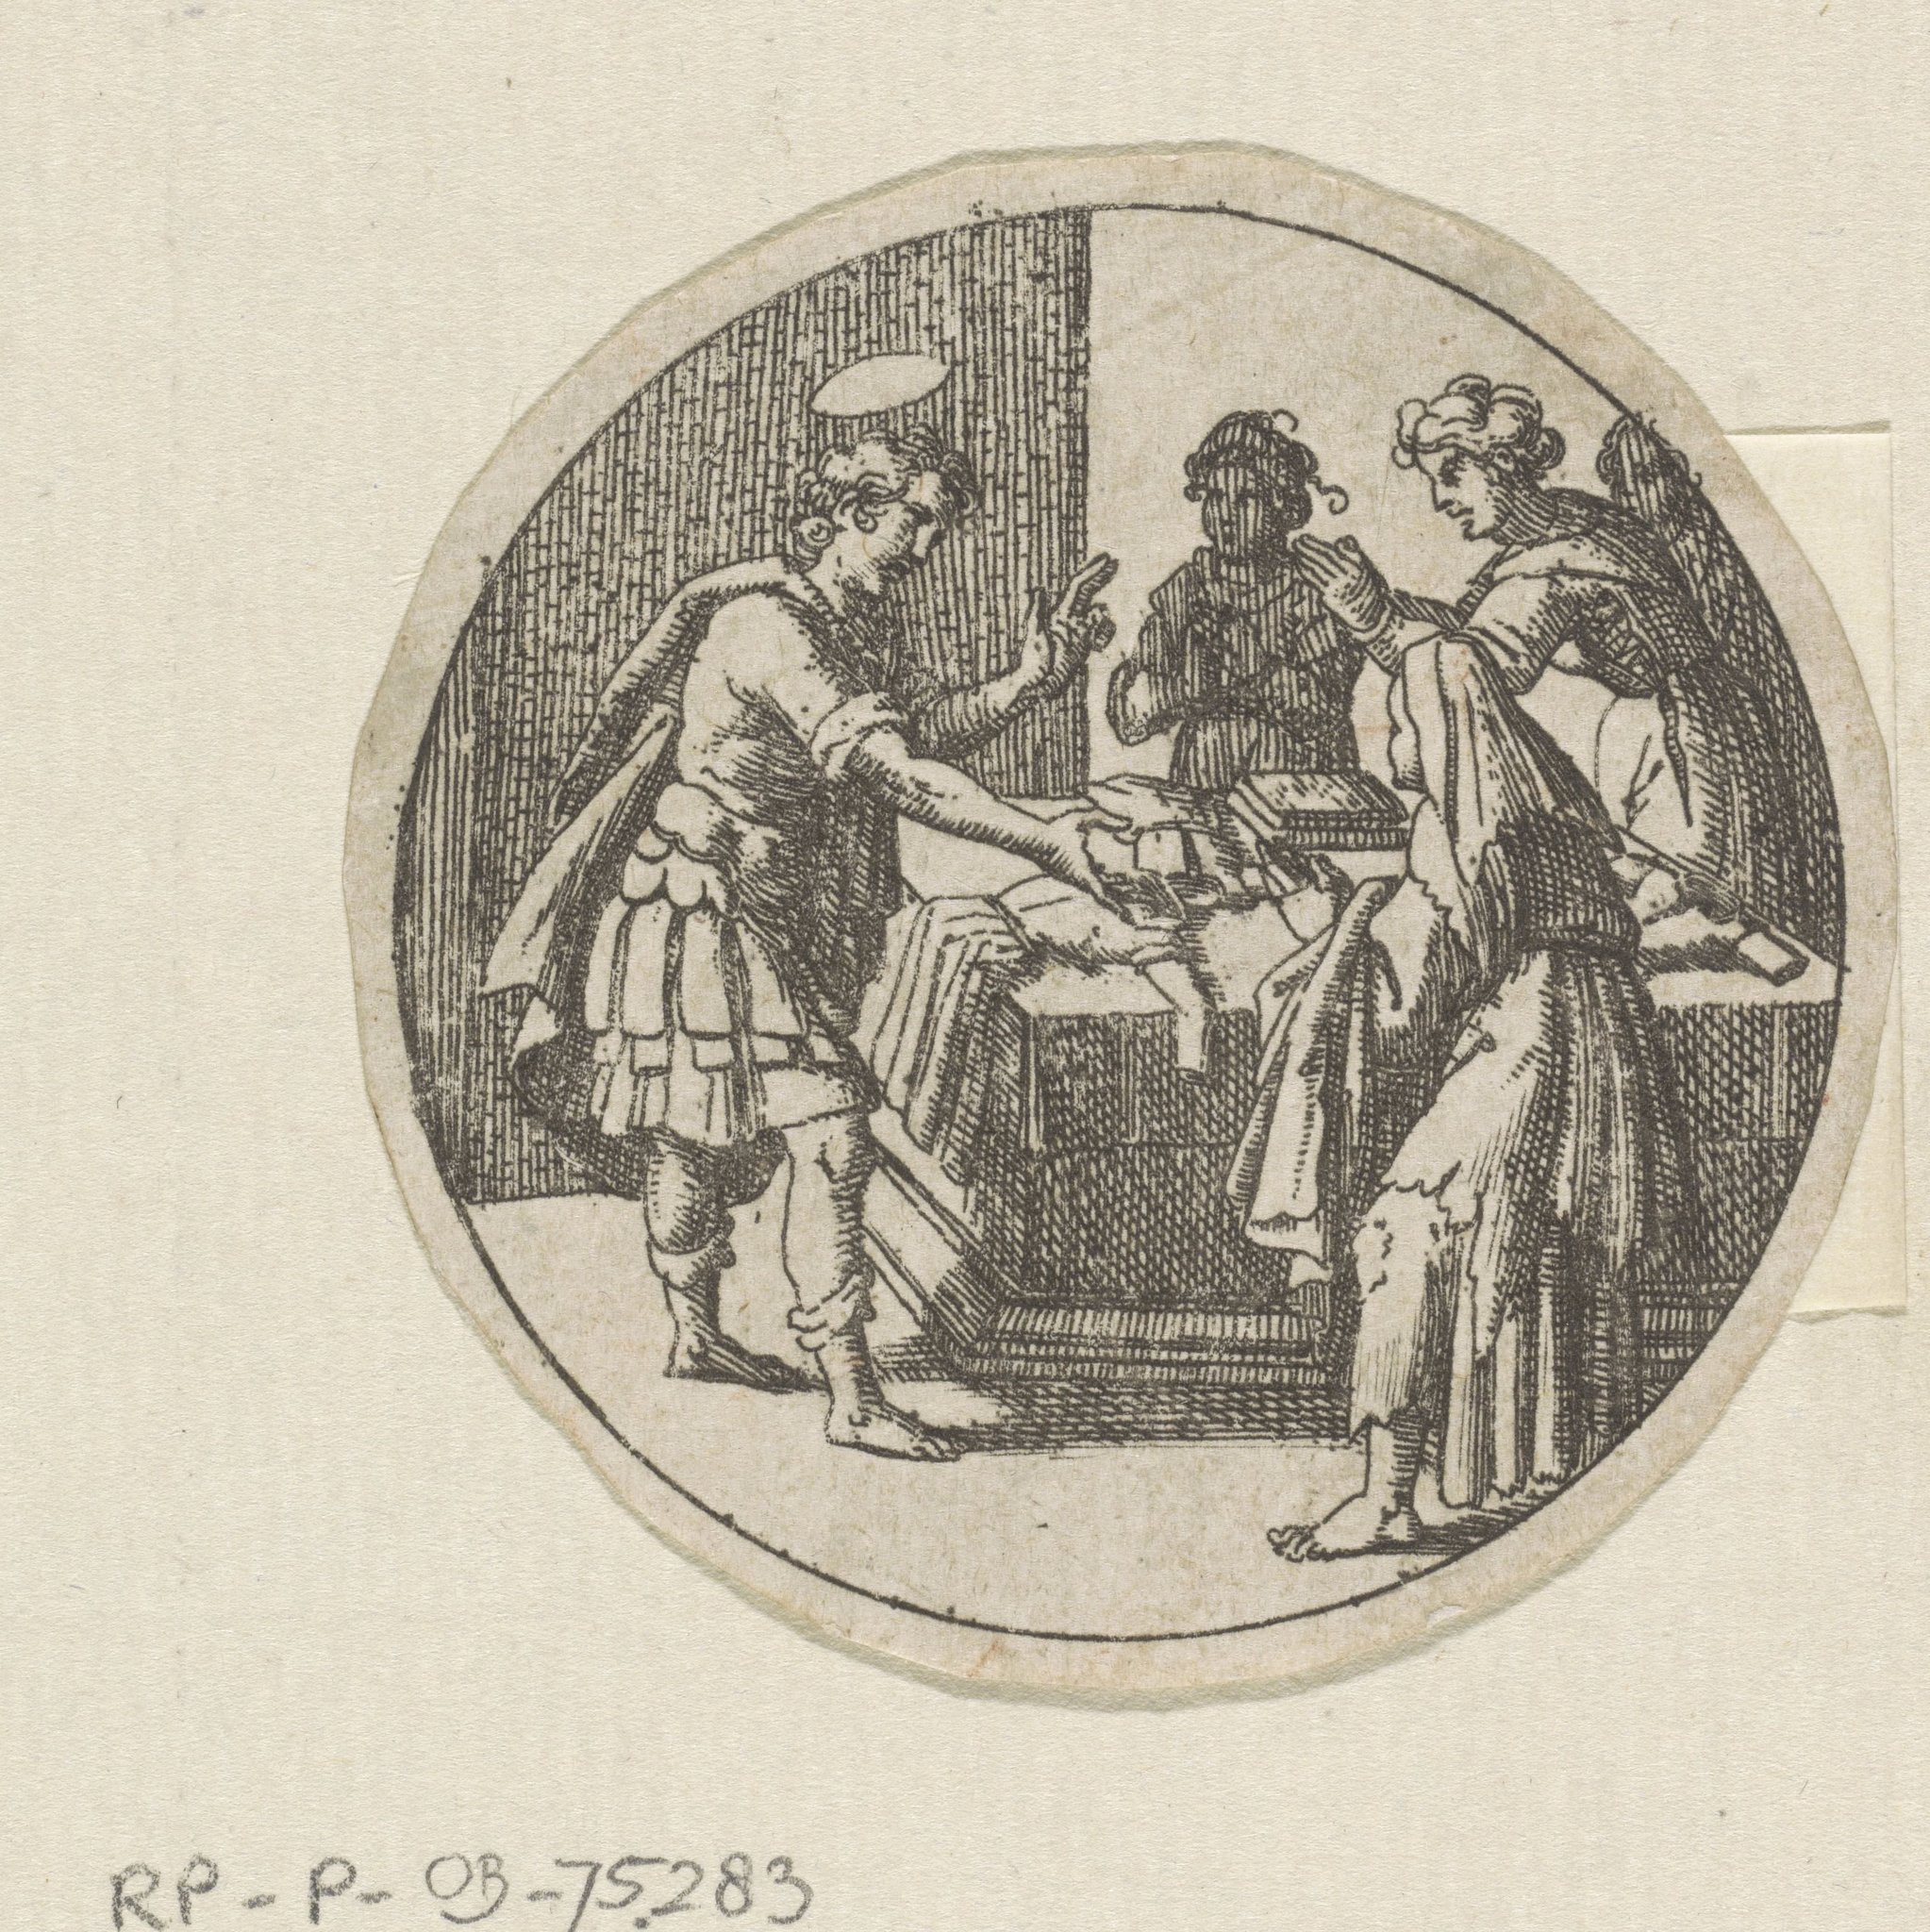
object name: print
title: Verschijning van een heilige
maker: Anonymous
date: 1600-1750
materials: paper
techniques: etching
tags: male saints (with name) - posthumous deeds, appearances of male saints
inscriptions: collector's mark: Lugt 240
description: Een heilige met aureool boven het hoofd verschijnt aan mensen die hem met gevouwen handen aanbidden. Hij staat bij een tafel waarop kleding ligt.